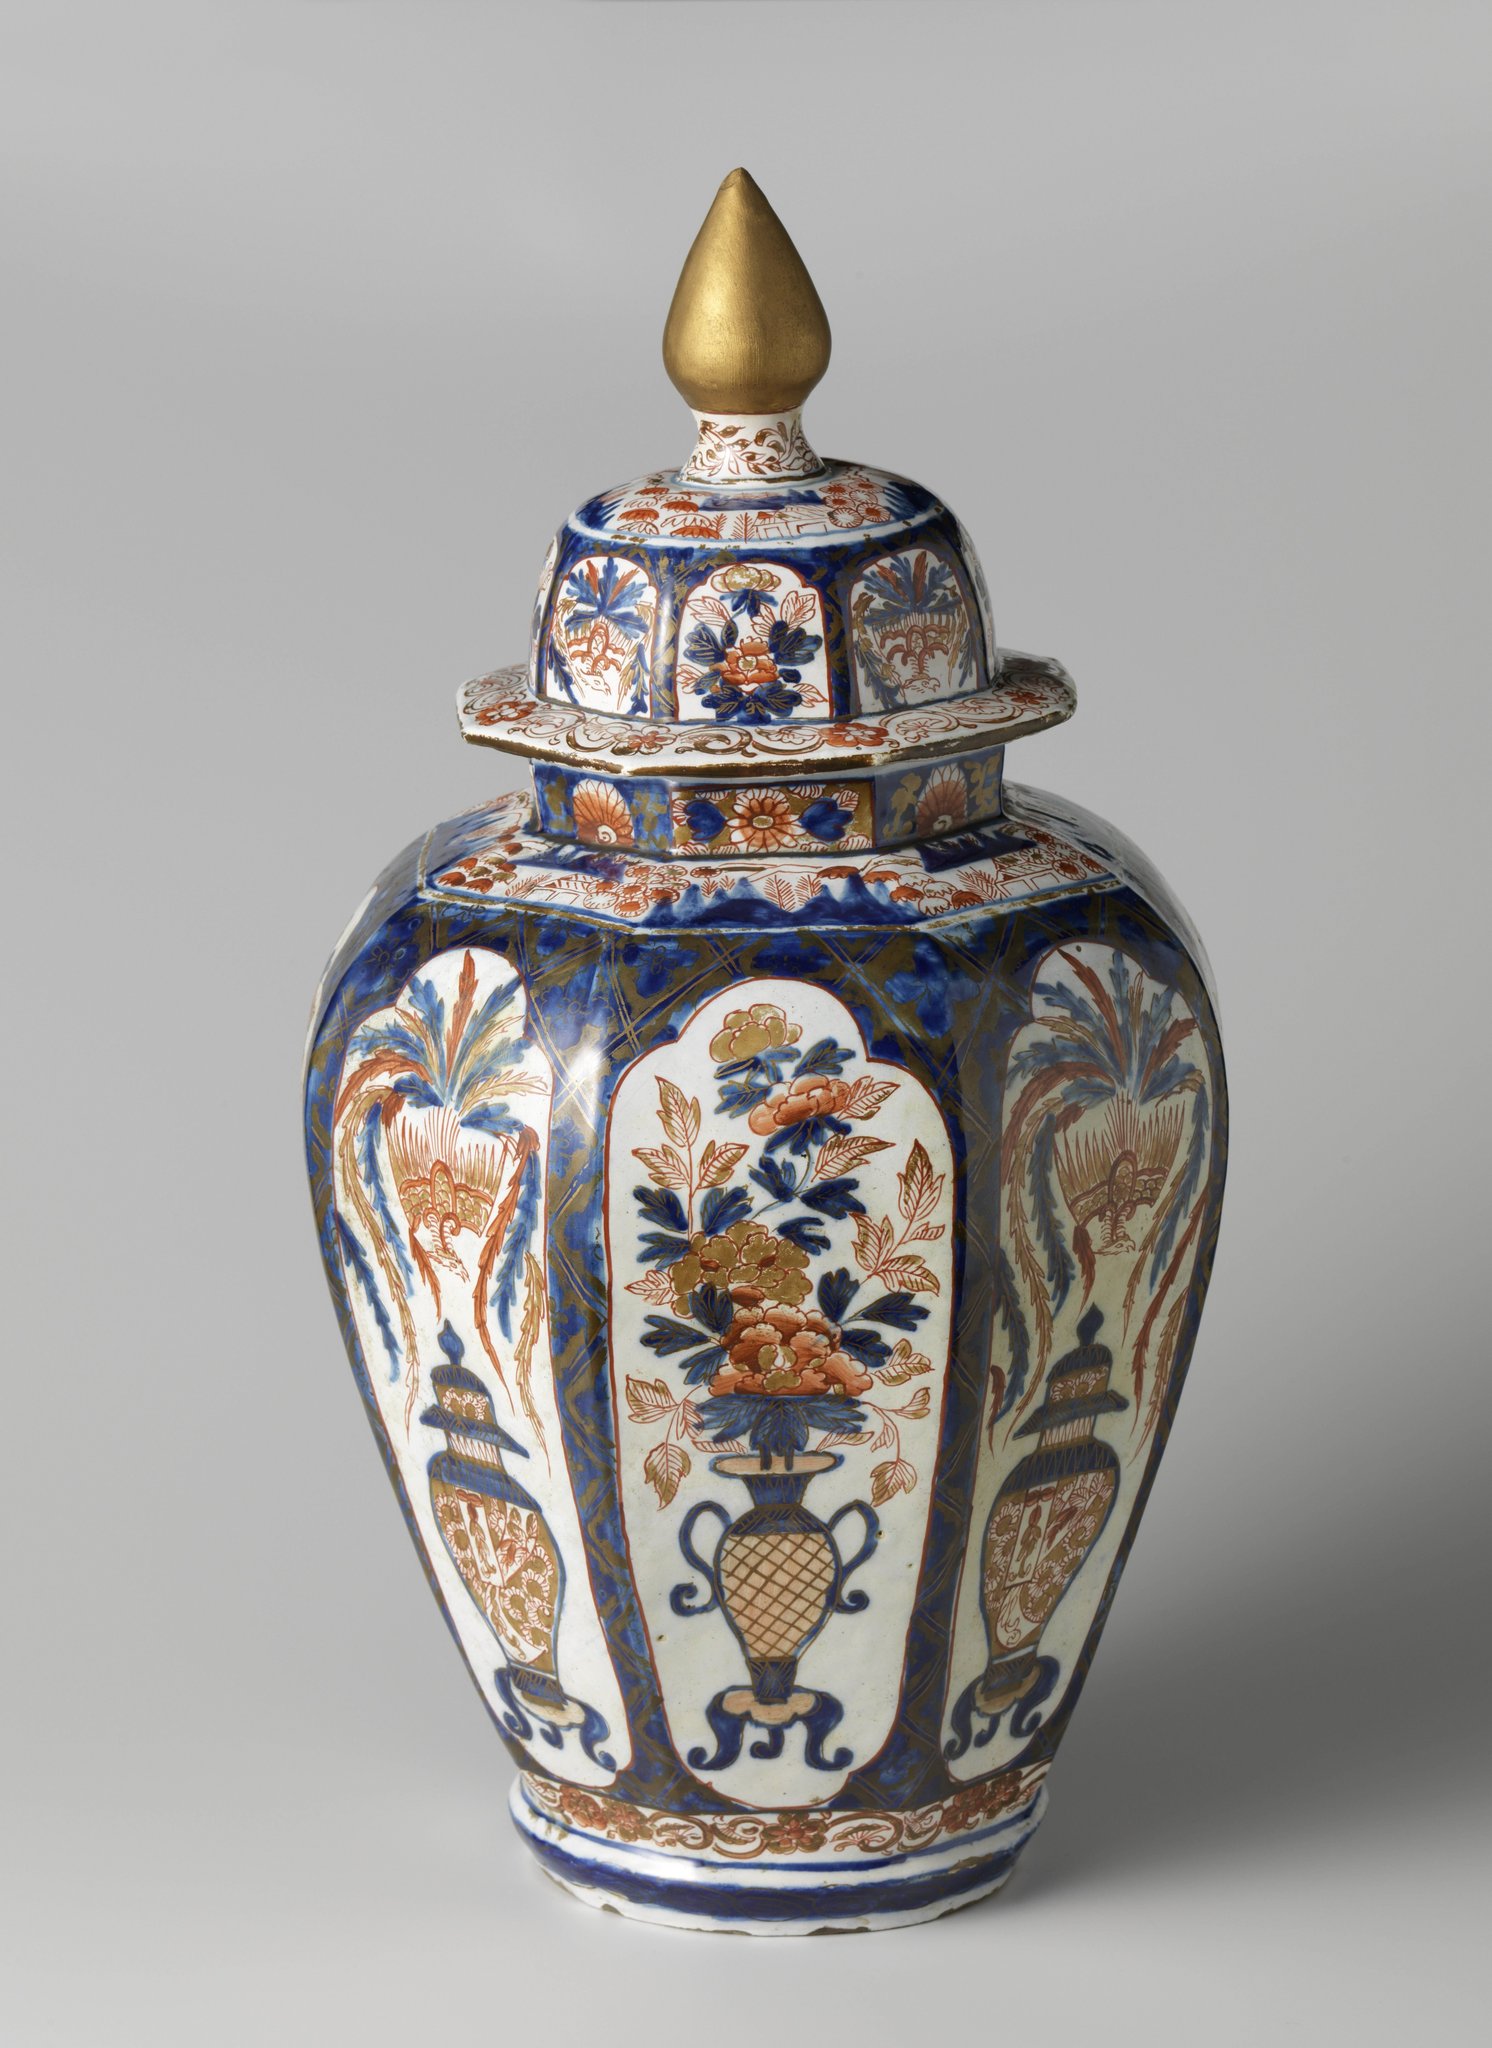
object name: covered jar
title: Deksel van een pot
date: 1820-1850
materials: earthenware, glaze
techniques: painted, polychromy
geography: delft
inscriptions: collector's mark: ‘collection J.F. Loudon’, mark: ‘IVP & C’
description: Deksel van veelkleurig beschilderde faïence. De pot is achtkantig en op de acht kanten zijn acht vakken geschilderd. In vier vakken is een vaas met twee s-vormige handvatten, staand op een driepotig voetstuk en gevuld met bloemen geschilderd, in de andere vier vakken een pot met deksel op een driepotig voetstuk waarboven een feniks. De pot is onderdeel van een stel en is gemerkt.